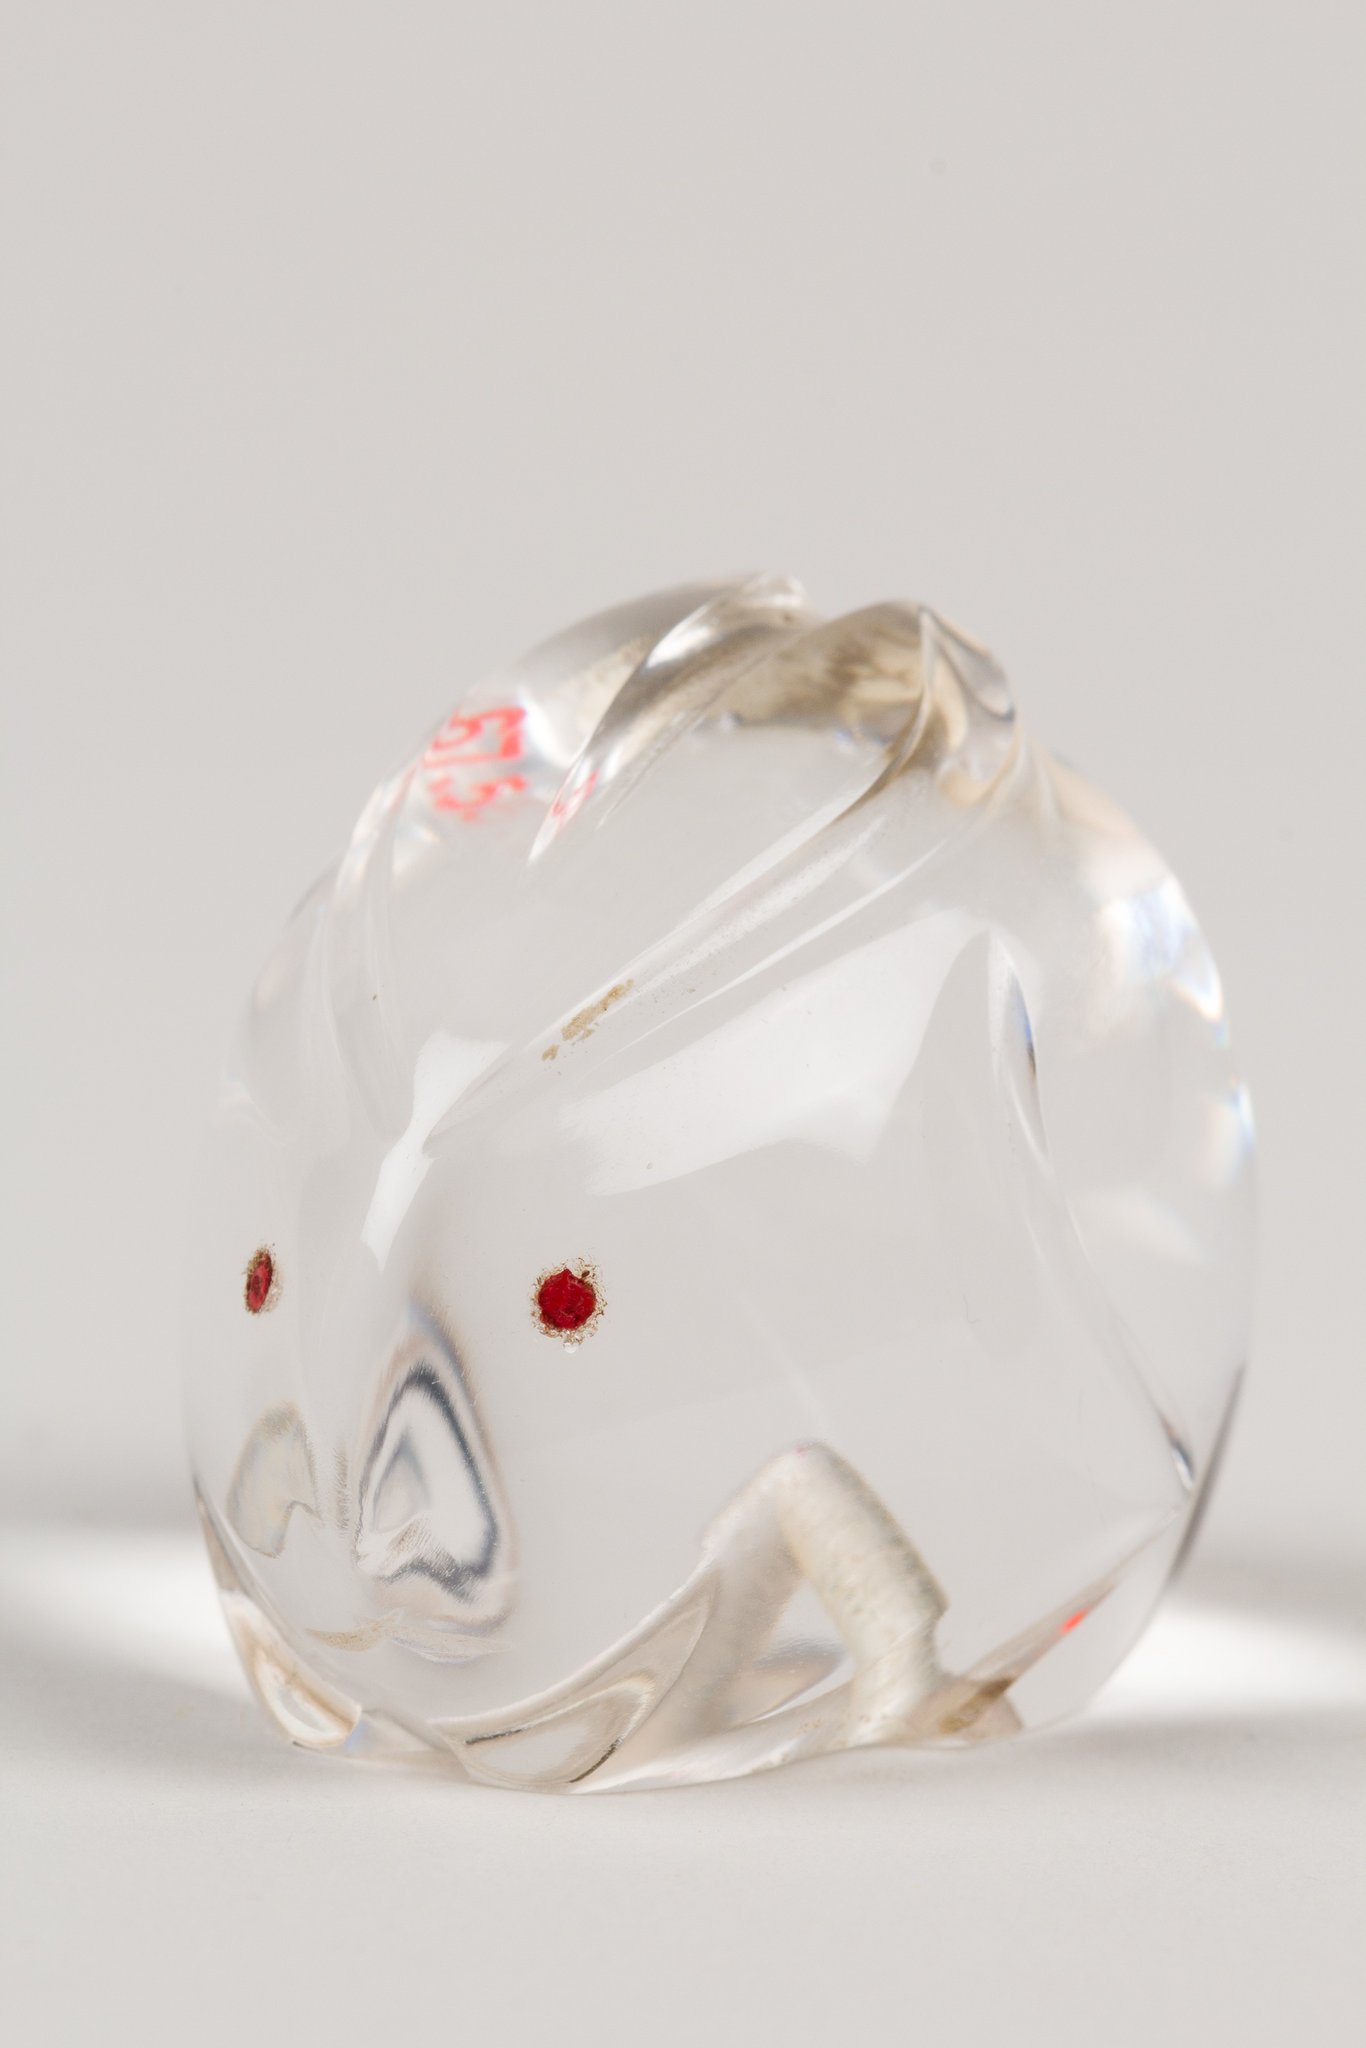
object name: netsuke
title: Netsuke of Rabbit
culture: japanese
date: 1901-2000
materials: crystal, wax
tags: rabbits